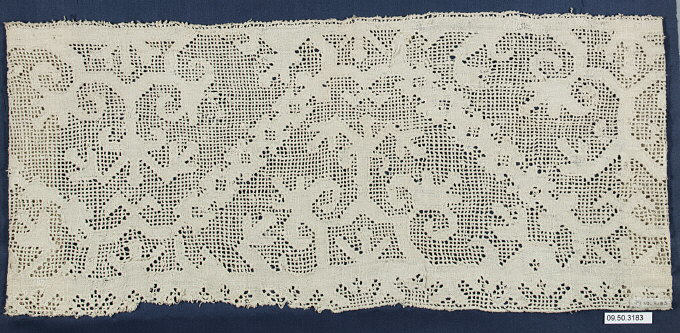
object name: border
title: Border fragment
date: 1501-1700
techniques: embroidery